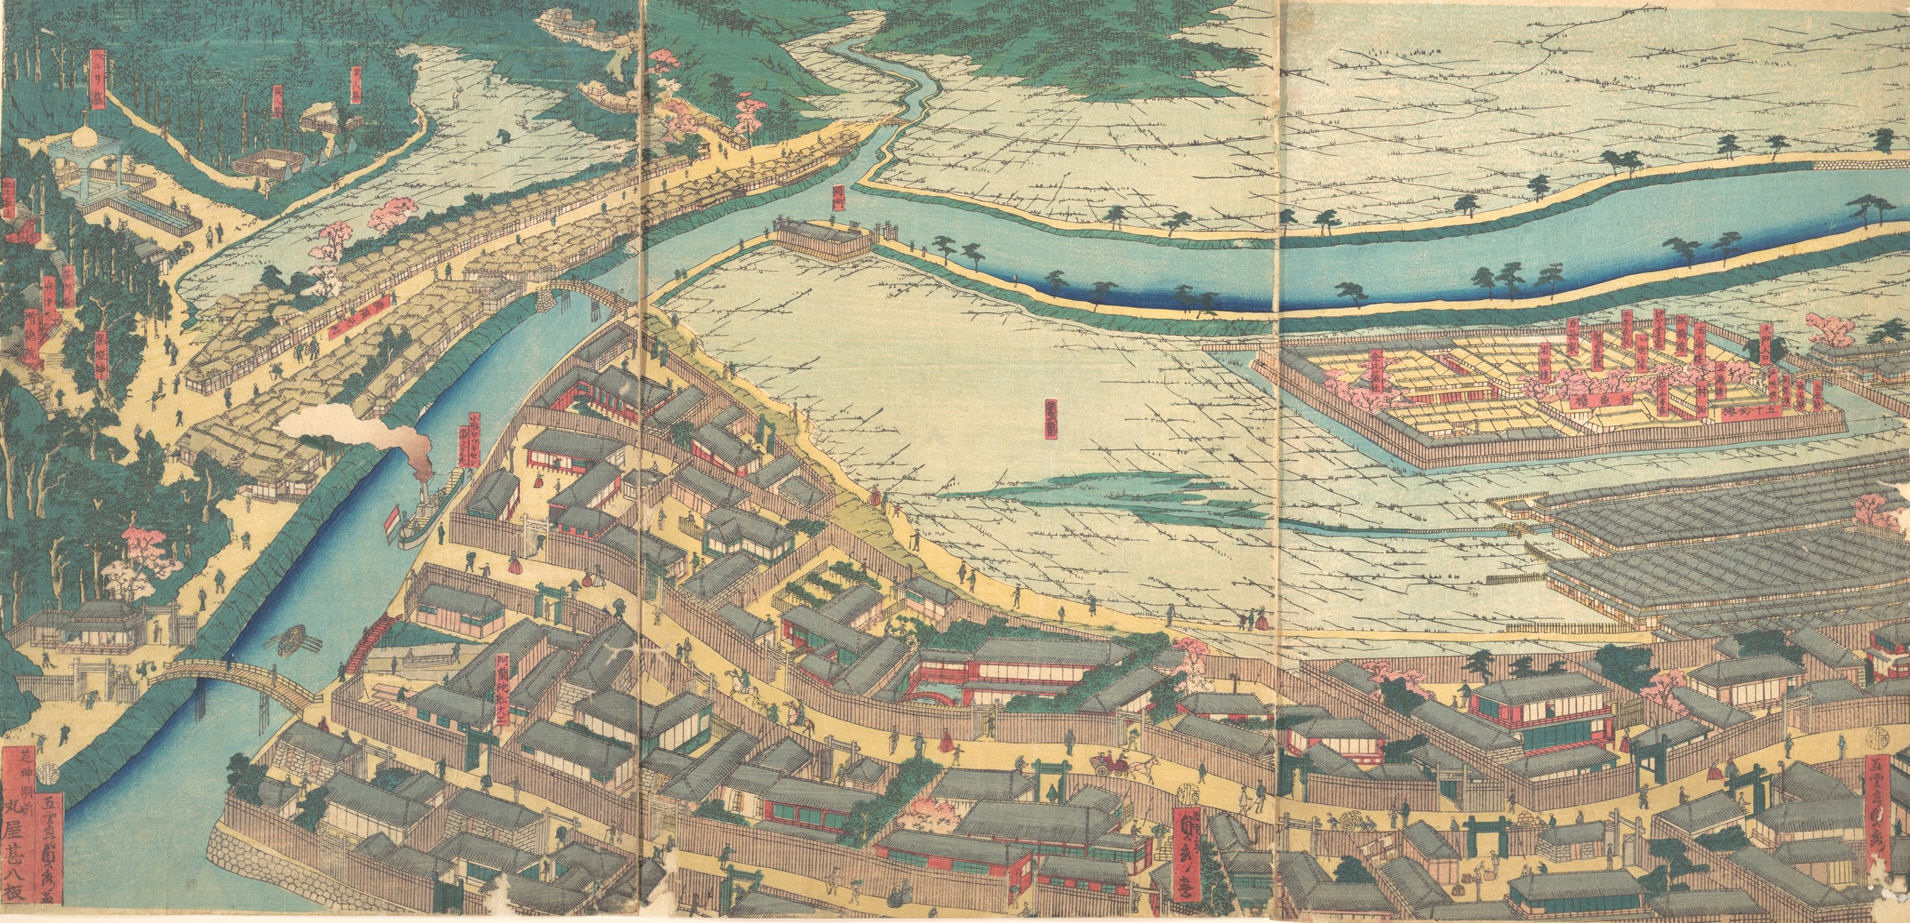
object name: print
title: Revised Yokohama Landscape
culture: japanese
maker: utagawa (gountei) sadahide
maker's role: artist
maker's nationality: japanese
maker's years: 1807-1873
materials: ink, paper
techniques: woodblock print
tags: towns,landscapes